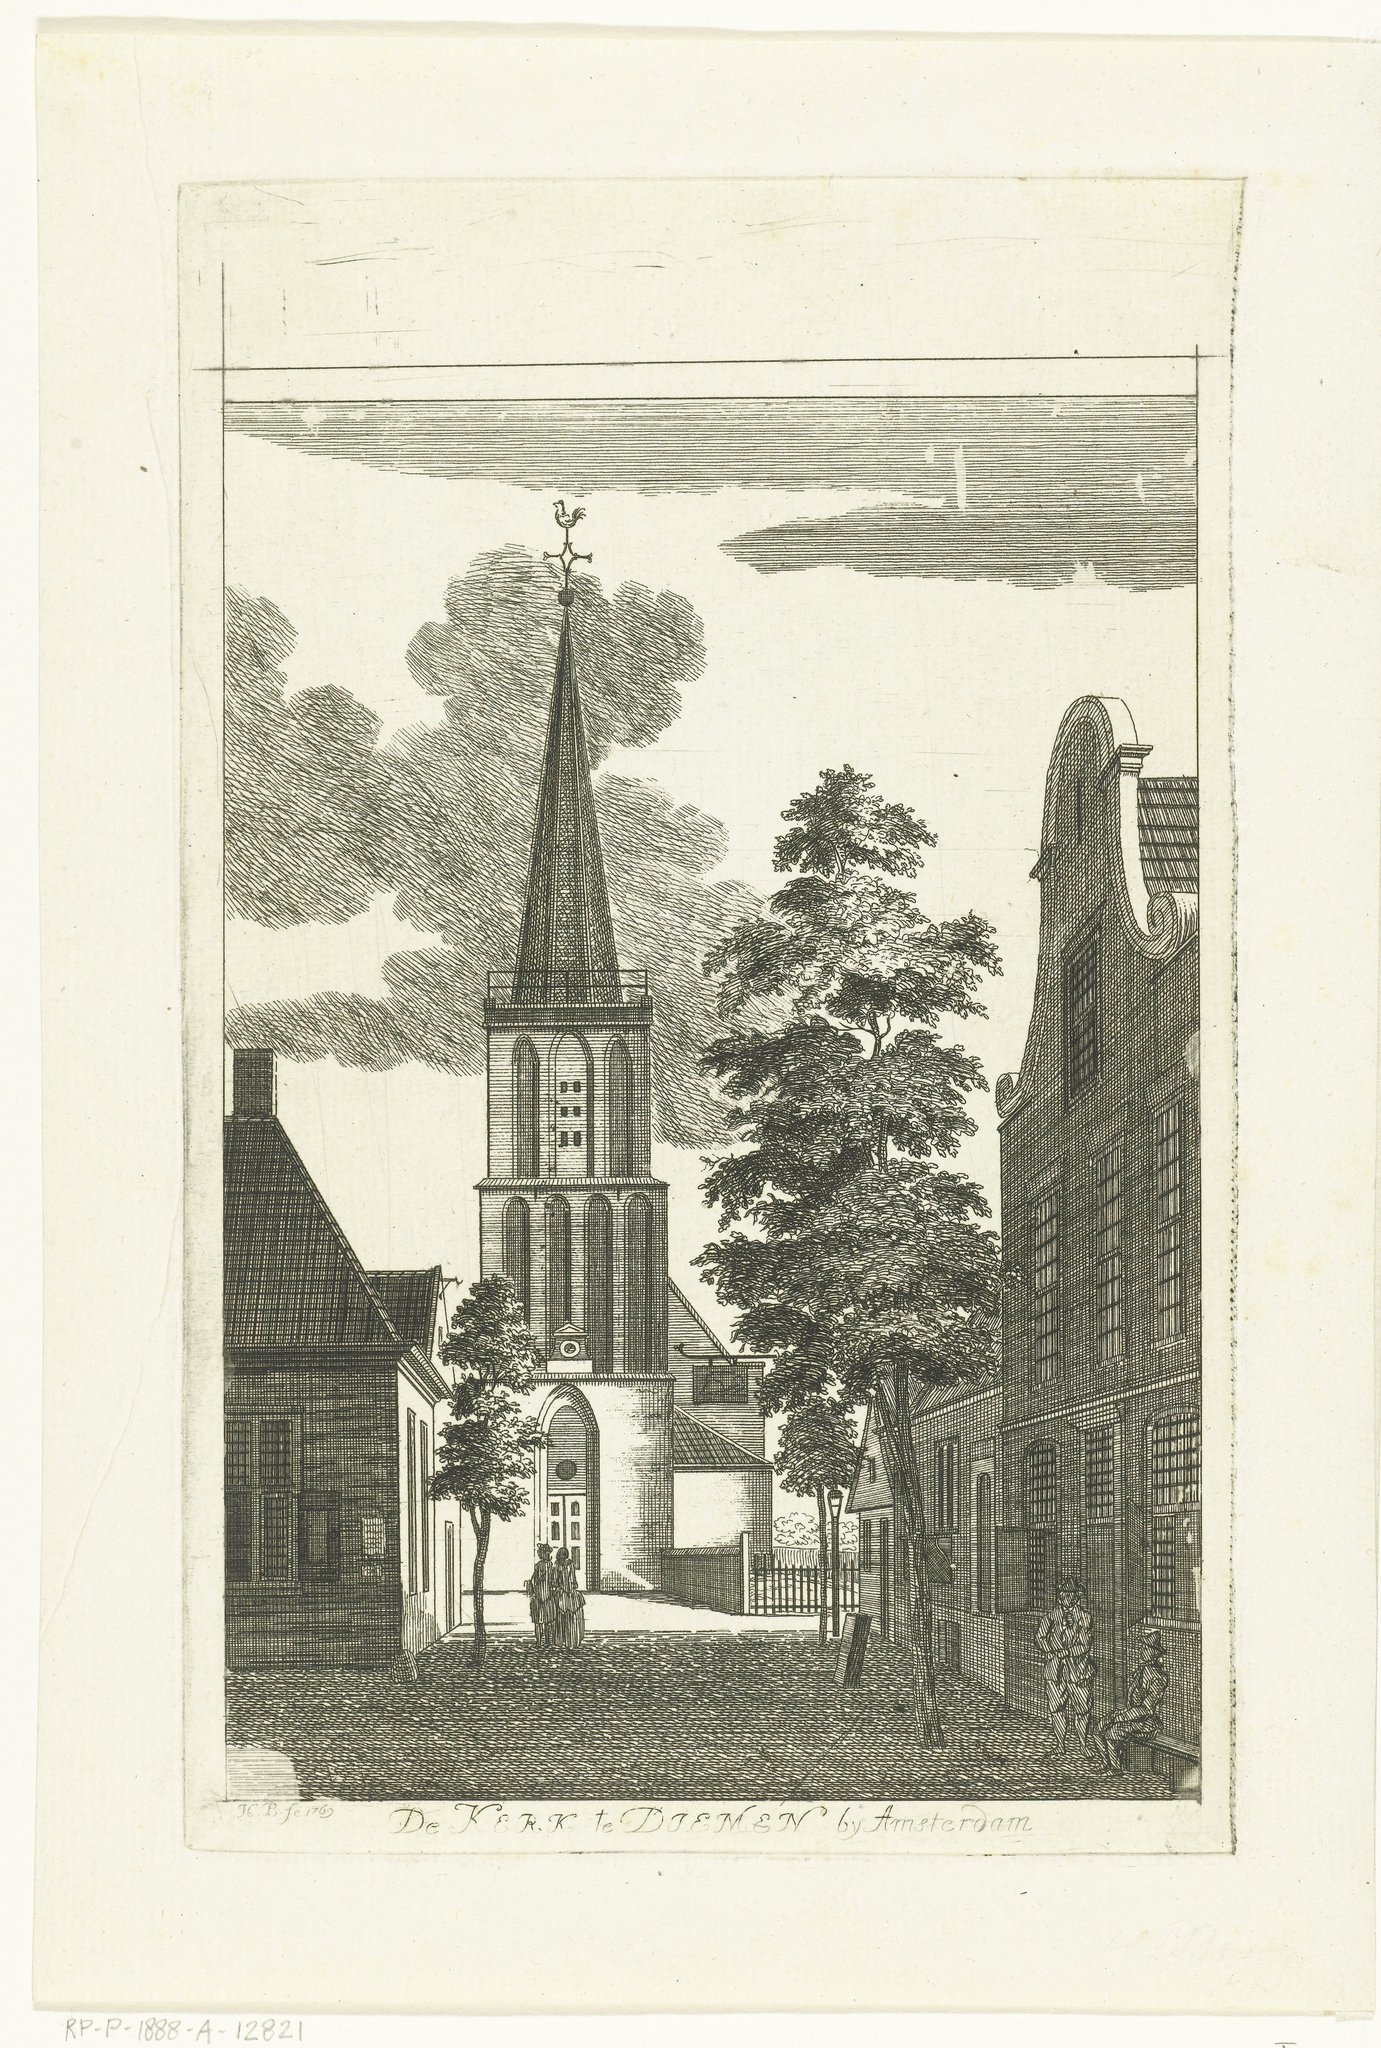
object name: print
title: De Kerk te Diemen bij Amsterdam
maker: hendrik berg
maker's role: print maker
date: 1769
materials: paper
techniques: etching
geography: amsterdam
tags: church (exterior)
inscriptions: collector's mark: Lugt 2228